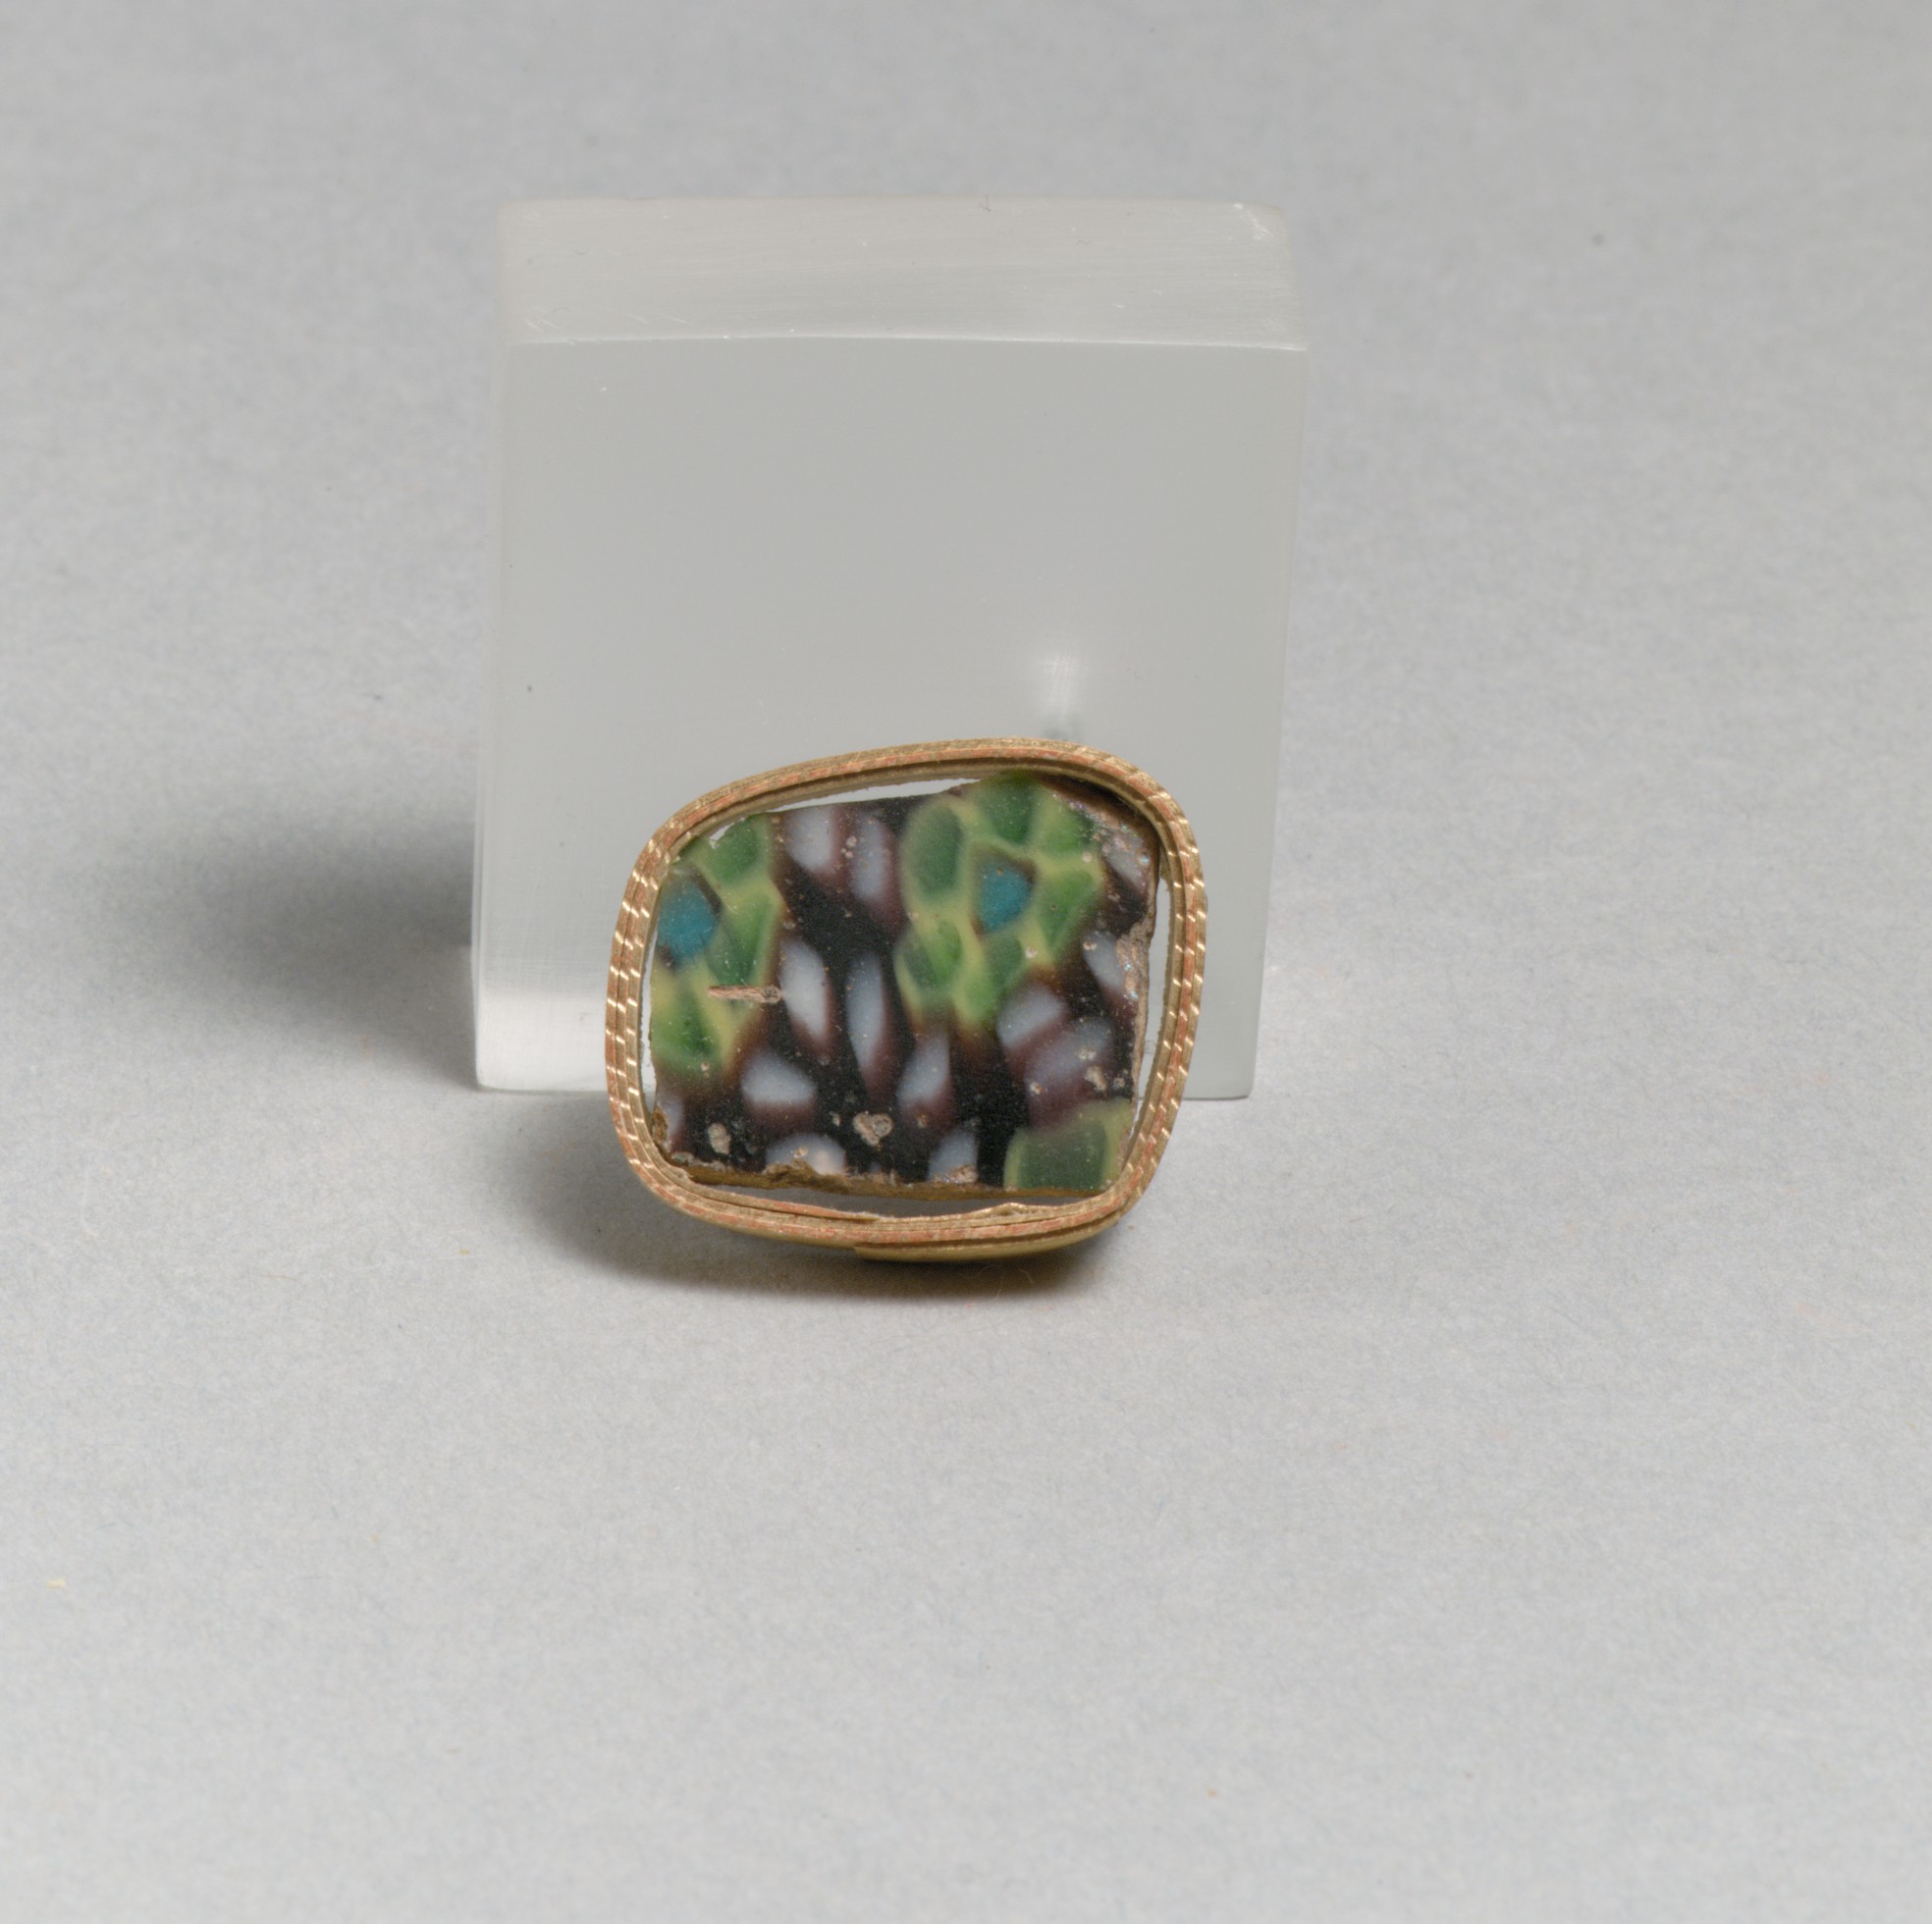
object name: fragment, mosaic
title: Glass mosaic inlay fragment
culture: roman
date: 34 BCE-33 CE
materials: glass